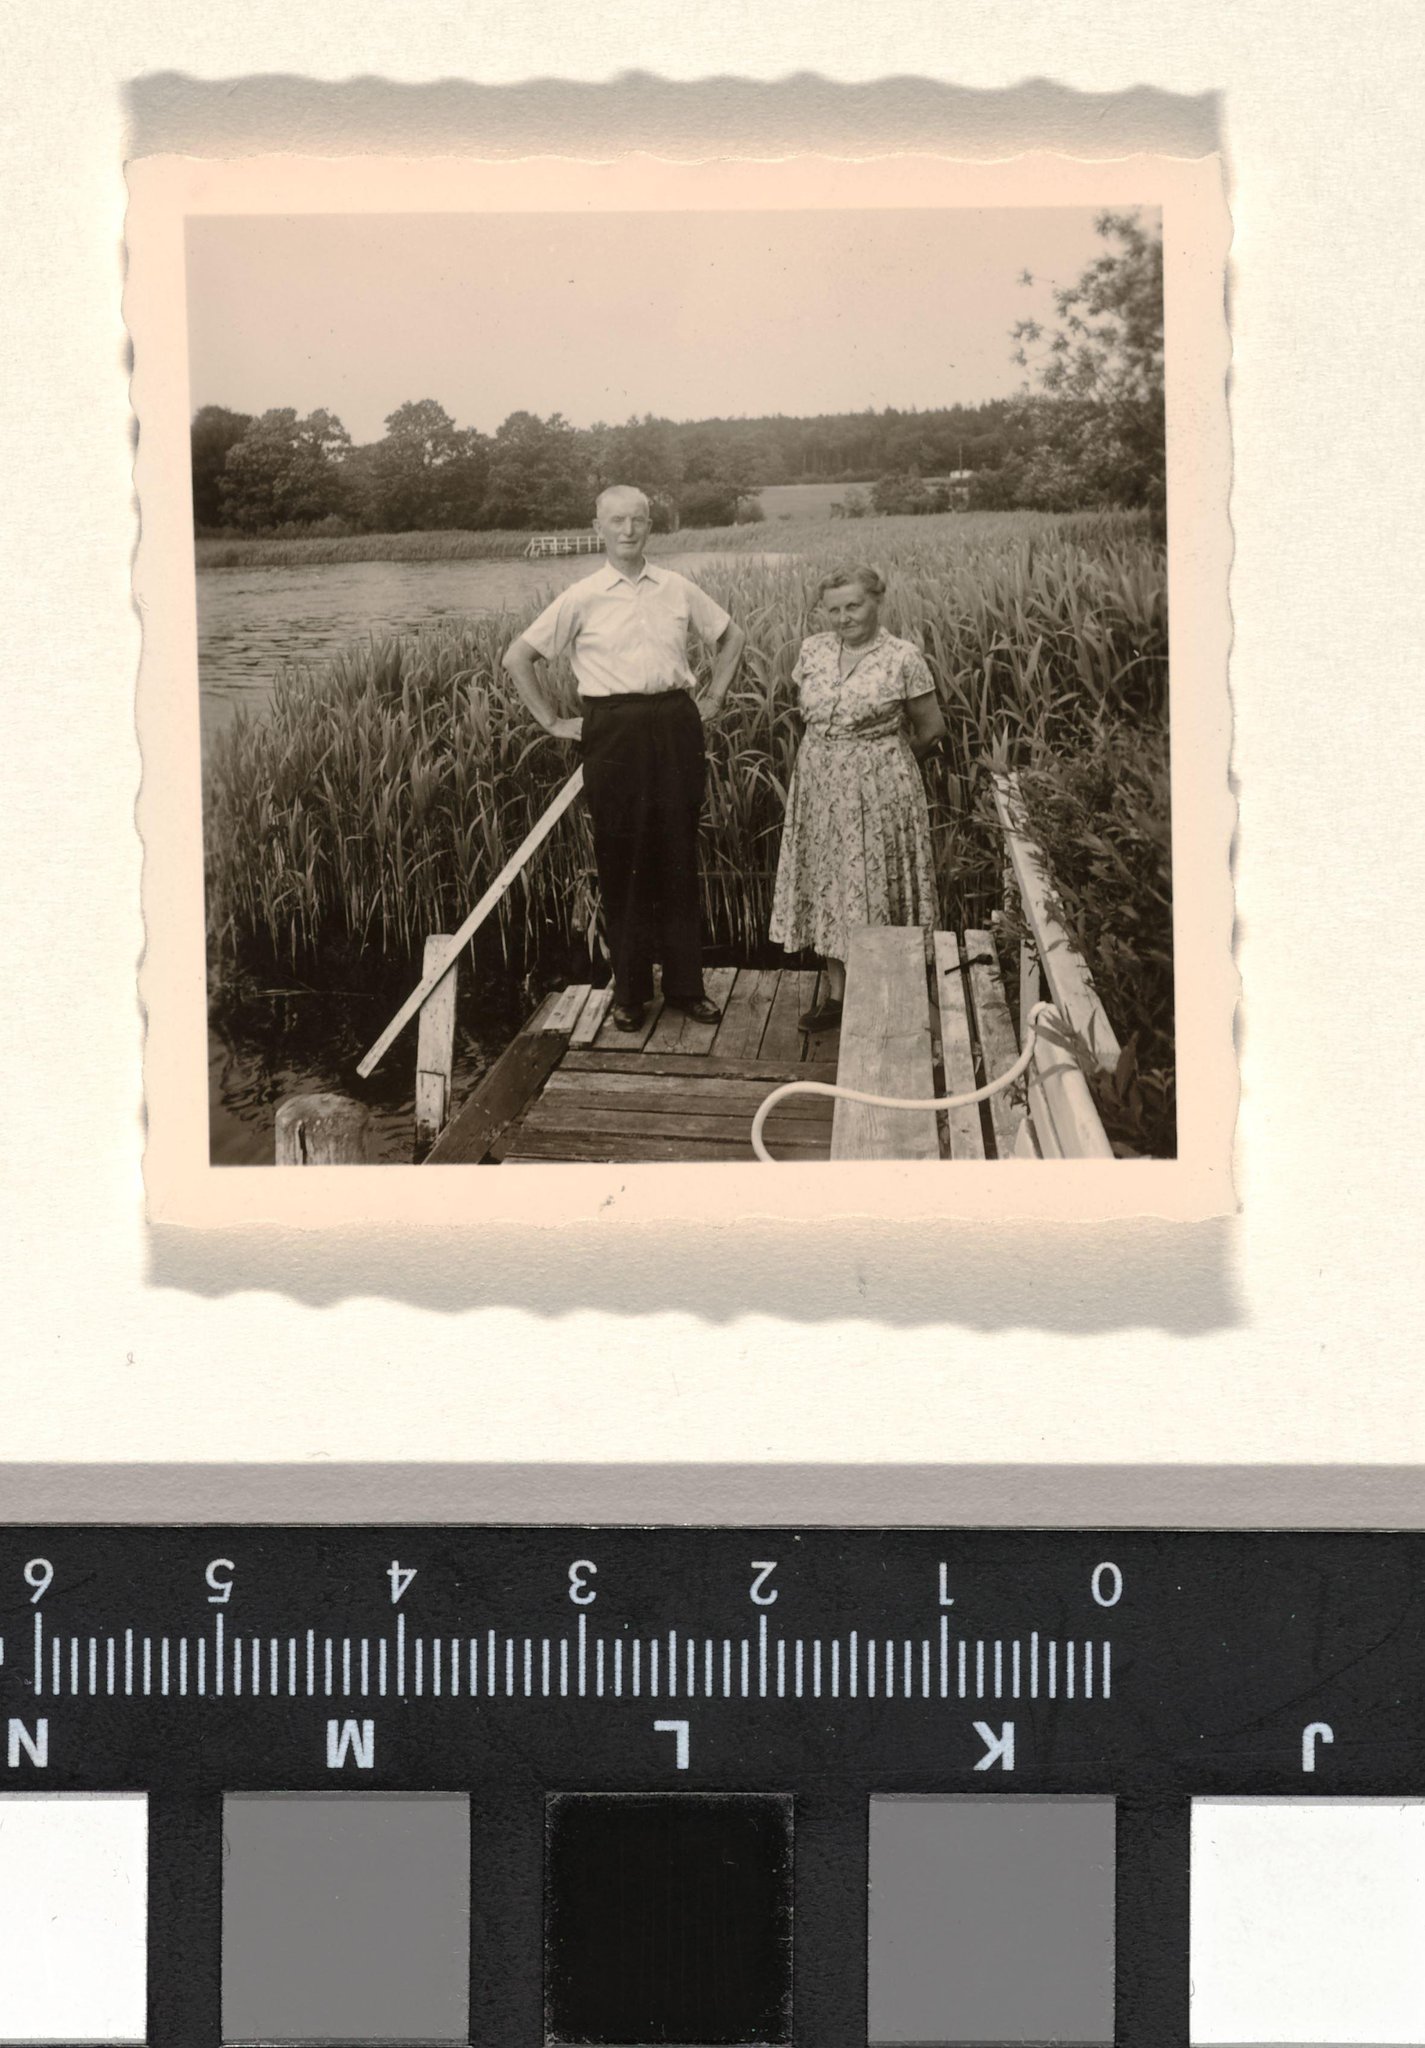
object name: photograph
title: Twee onbekende personen, vermoedelijk Onkel Julius en Rosel Tante, staand op een steiger met bankje bij een meer met riet op de oevers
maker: Anonymous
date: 1958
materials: photographic support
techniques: gelatin silver print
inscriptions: inscription: ‘20.6.58 ...’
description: Twee onbekende personen, vermoedelijk Onkel Julius en Rosel Tante, staand op een steiger met bankje bij een meer met riet op de oevers